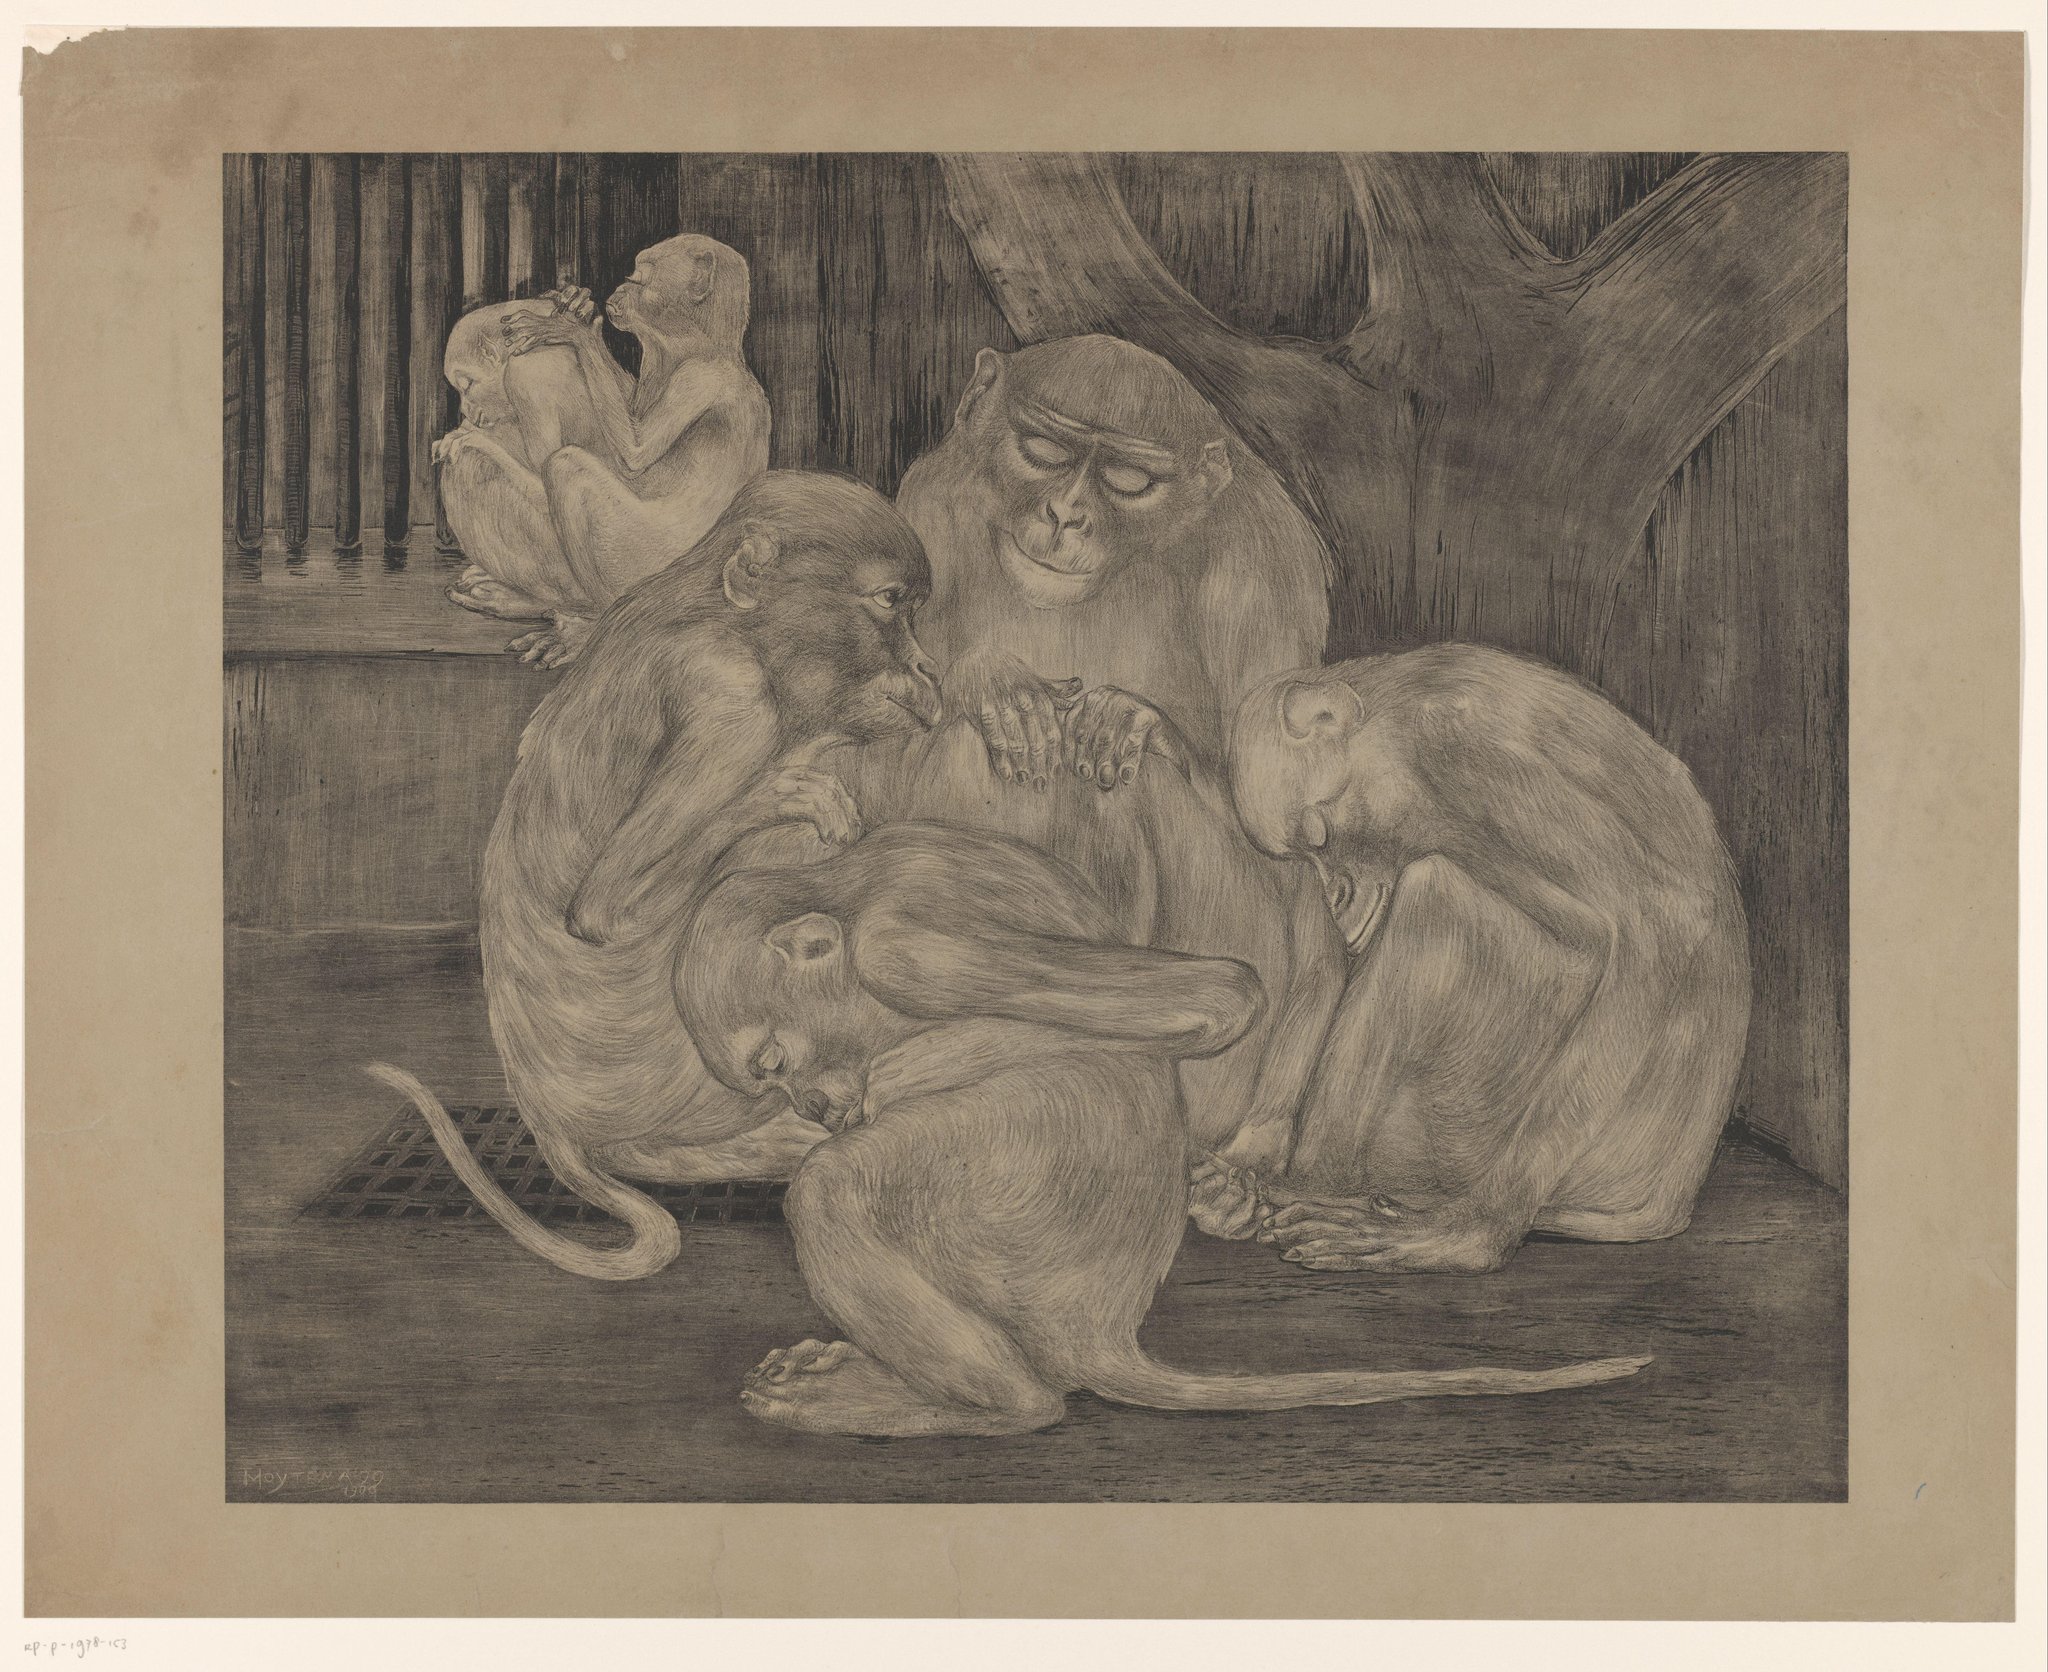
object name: print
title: Vijf apen in een hok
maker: theo van hoytema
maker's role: draughtsman, painter, print maker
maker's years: 1863-1917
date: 1899-1900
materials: paper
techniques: lithograph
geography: hilversum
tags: trees, monkeys, apes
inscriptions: collector's mark: Lugt 2760, collector's mark: Lugt 2228